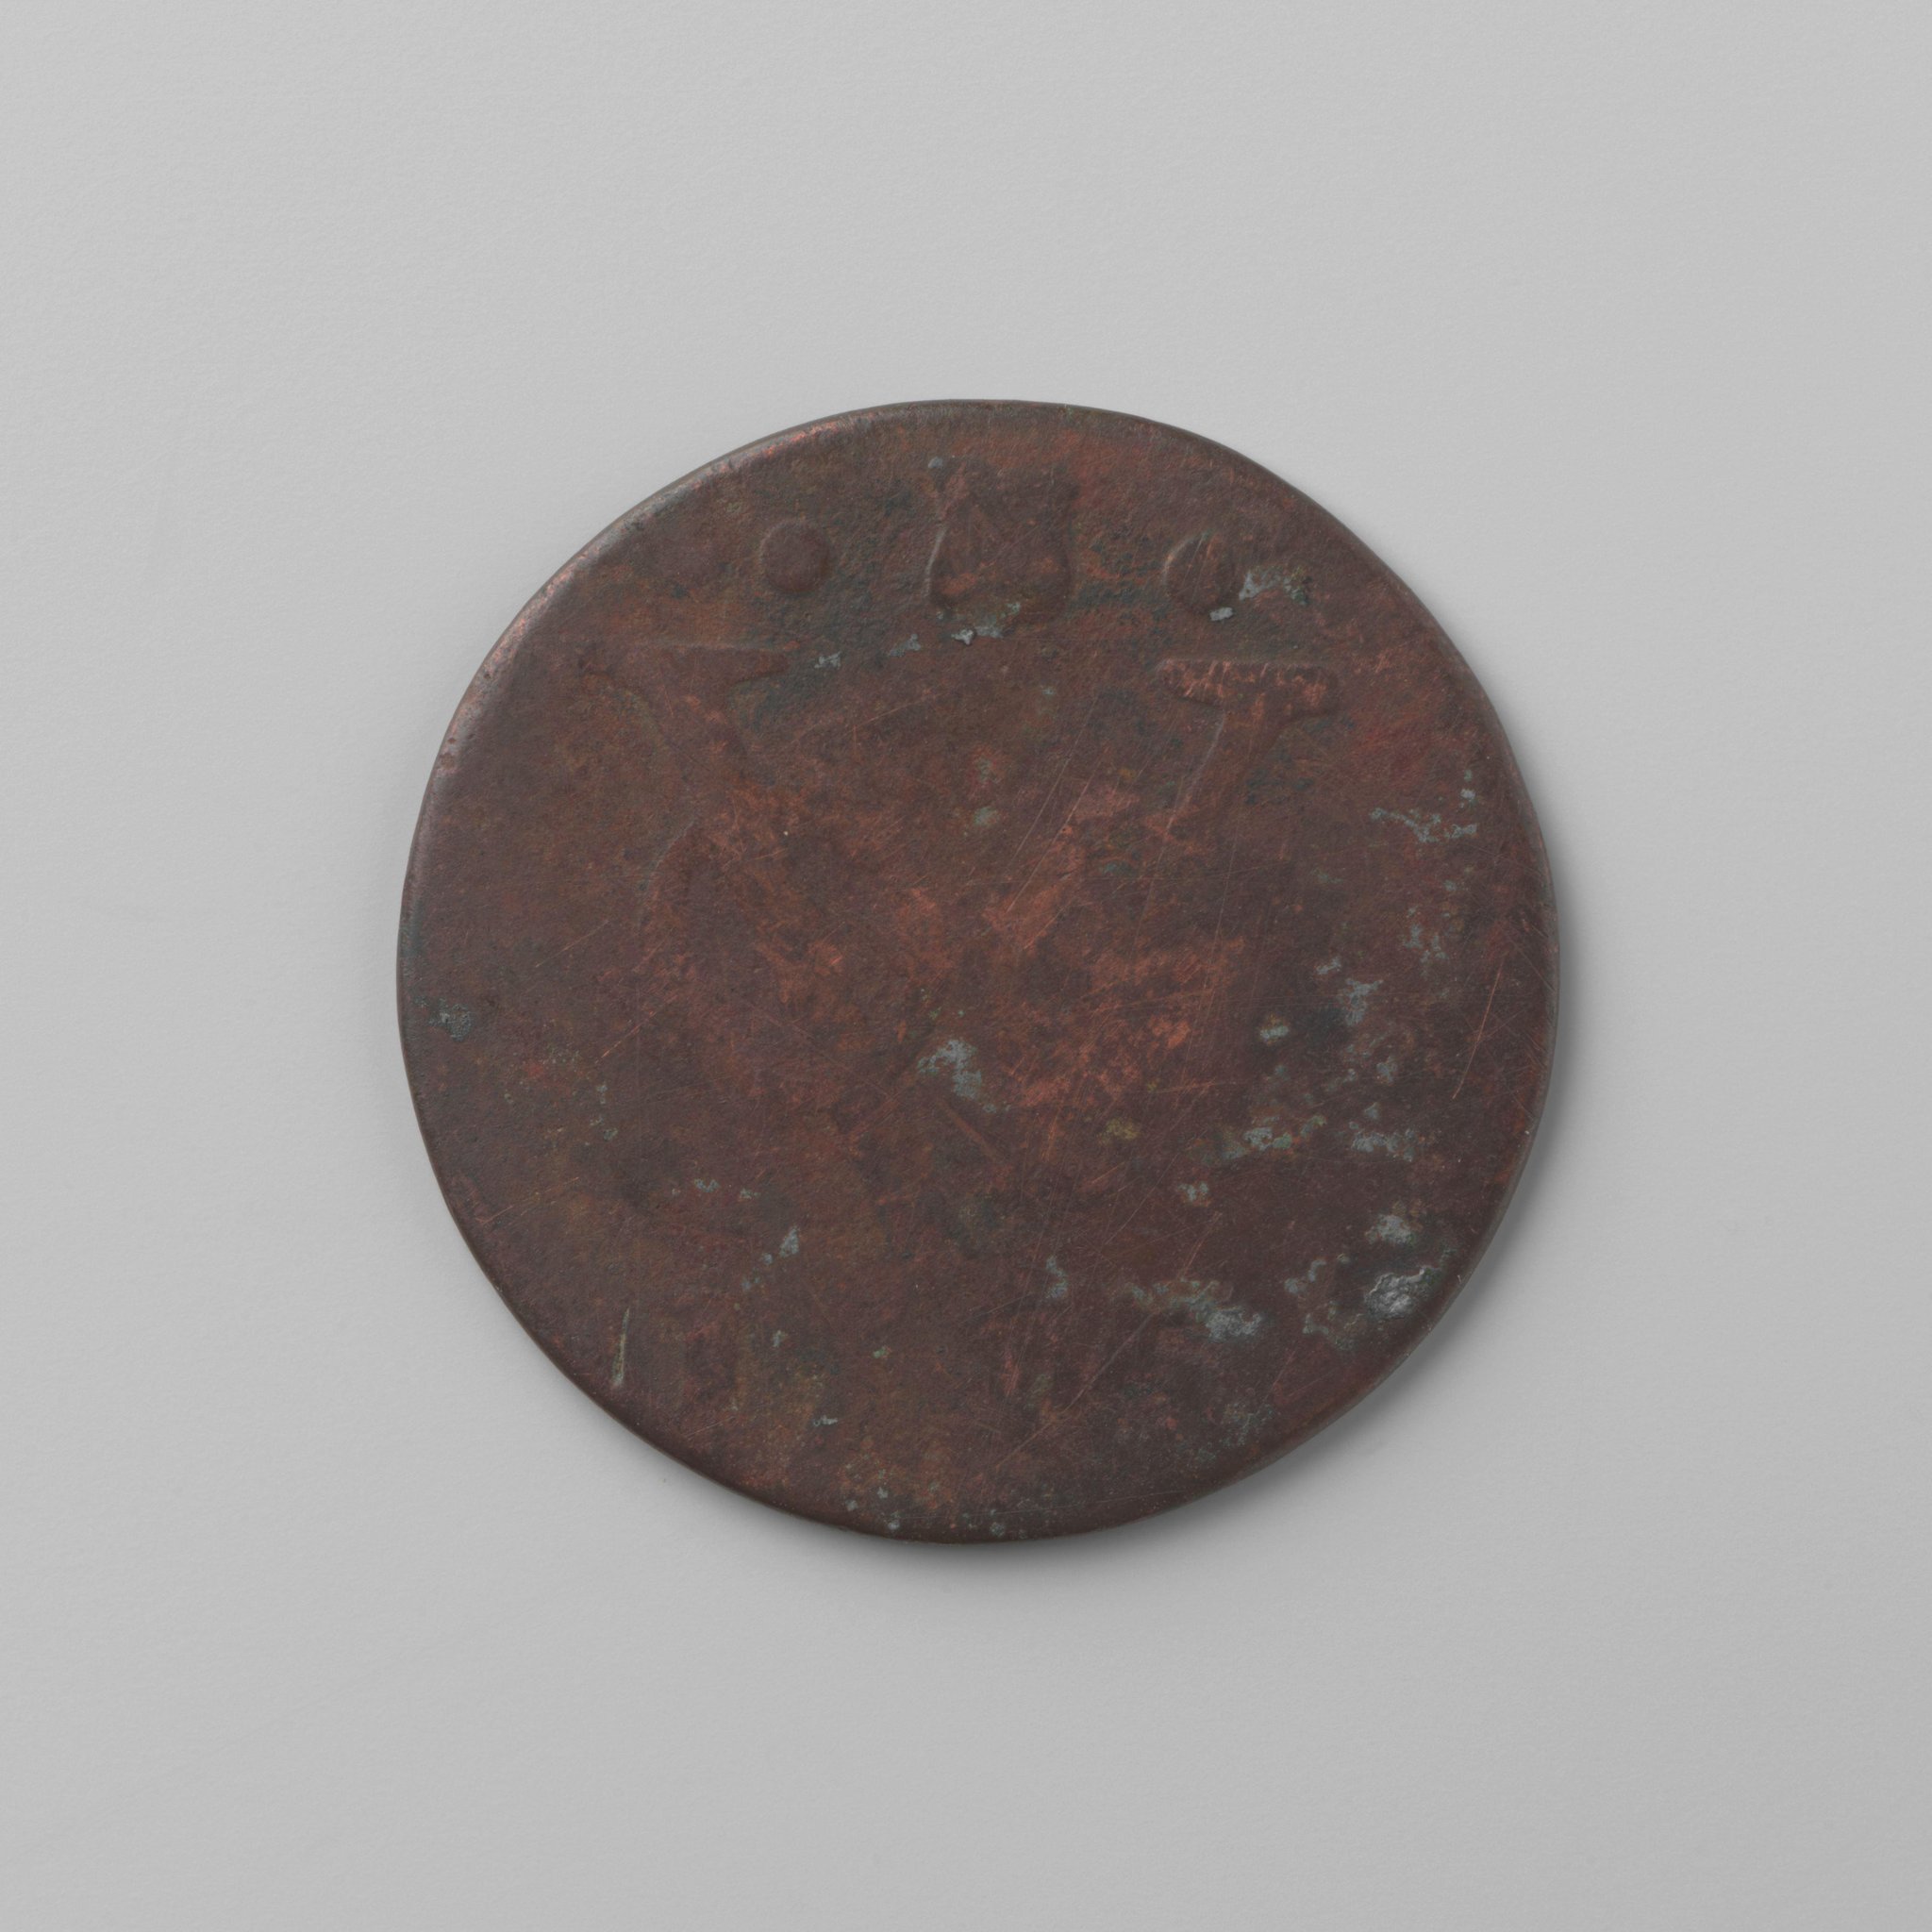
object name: coin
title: VOC, duit stad Utrecht,1745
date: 1745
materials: copper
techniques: striking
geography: utrecht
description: Koperen munt. Voorzijde: op balk, waaronder guirlande, geplaatst, door twee leeuwen gehouden gekroond wapenschild van de stad Utrecht. Keerzijde: monogram van de VOC, waarboven muntteken en waaronder jaartal. Gladde rand.